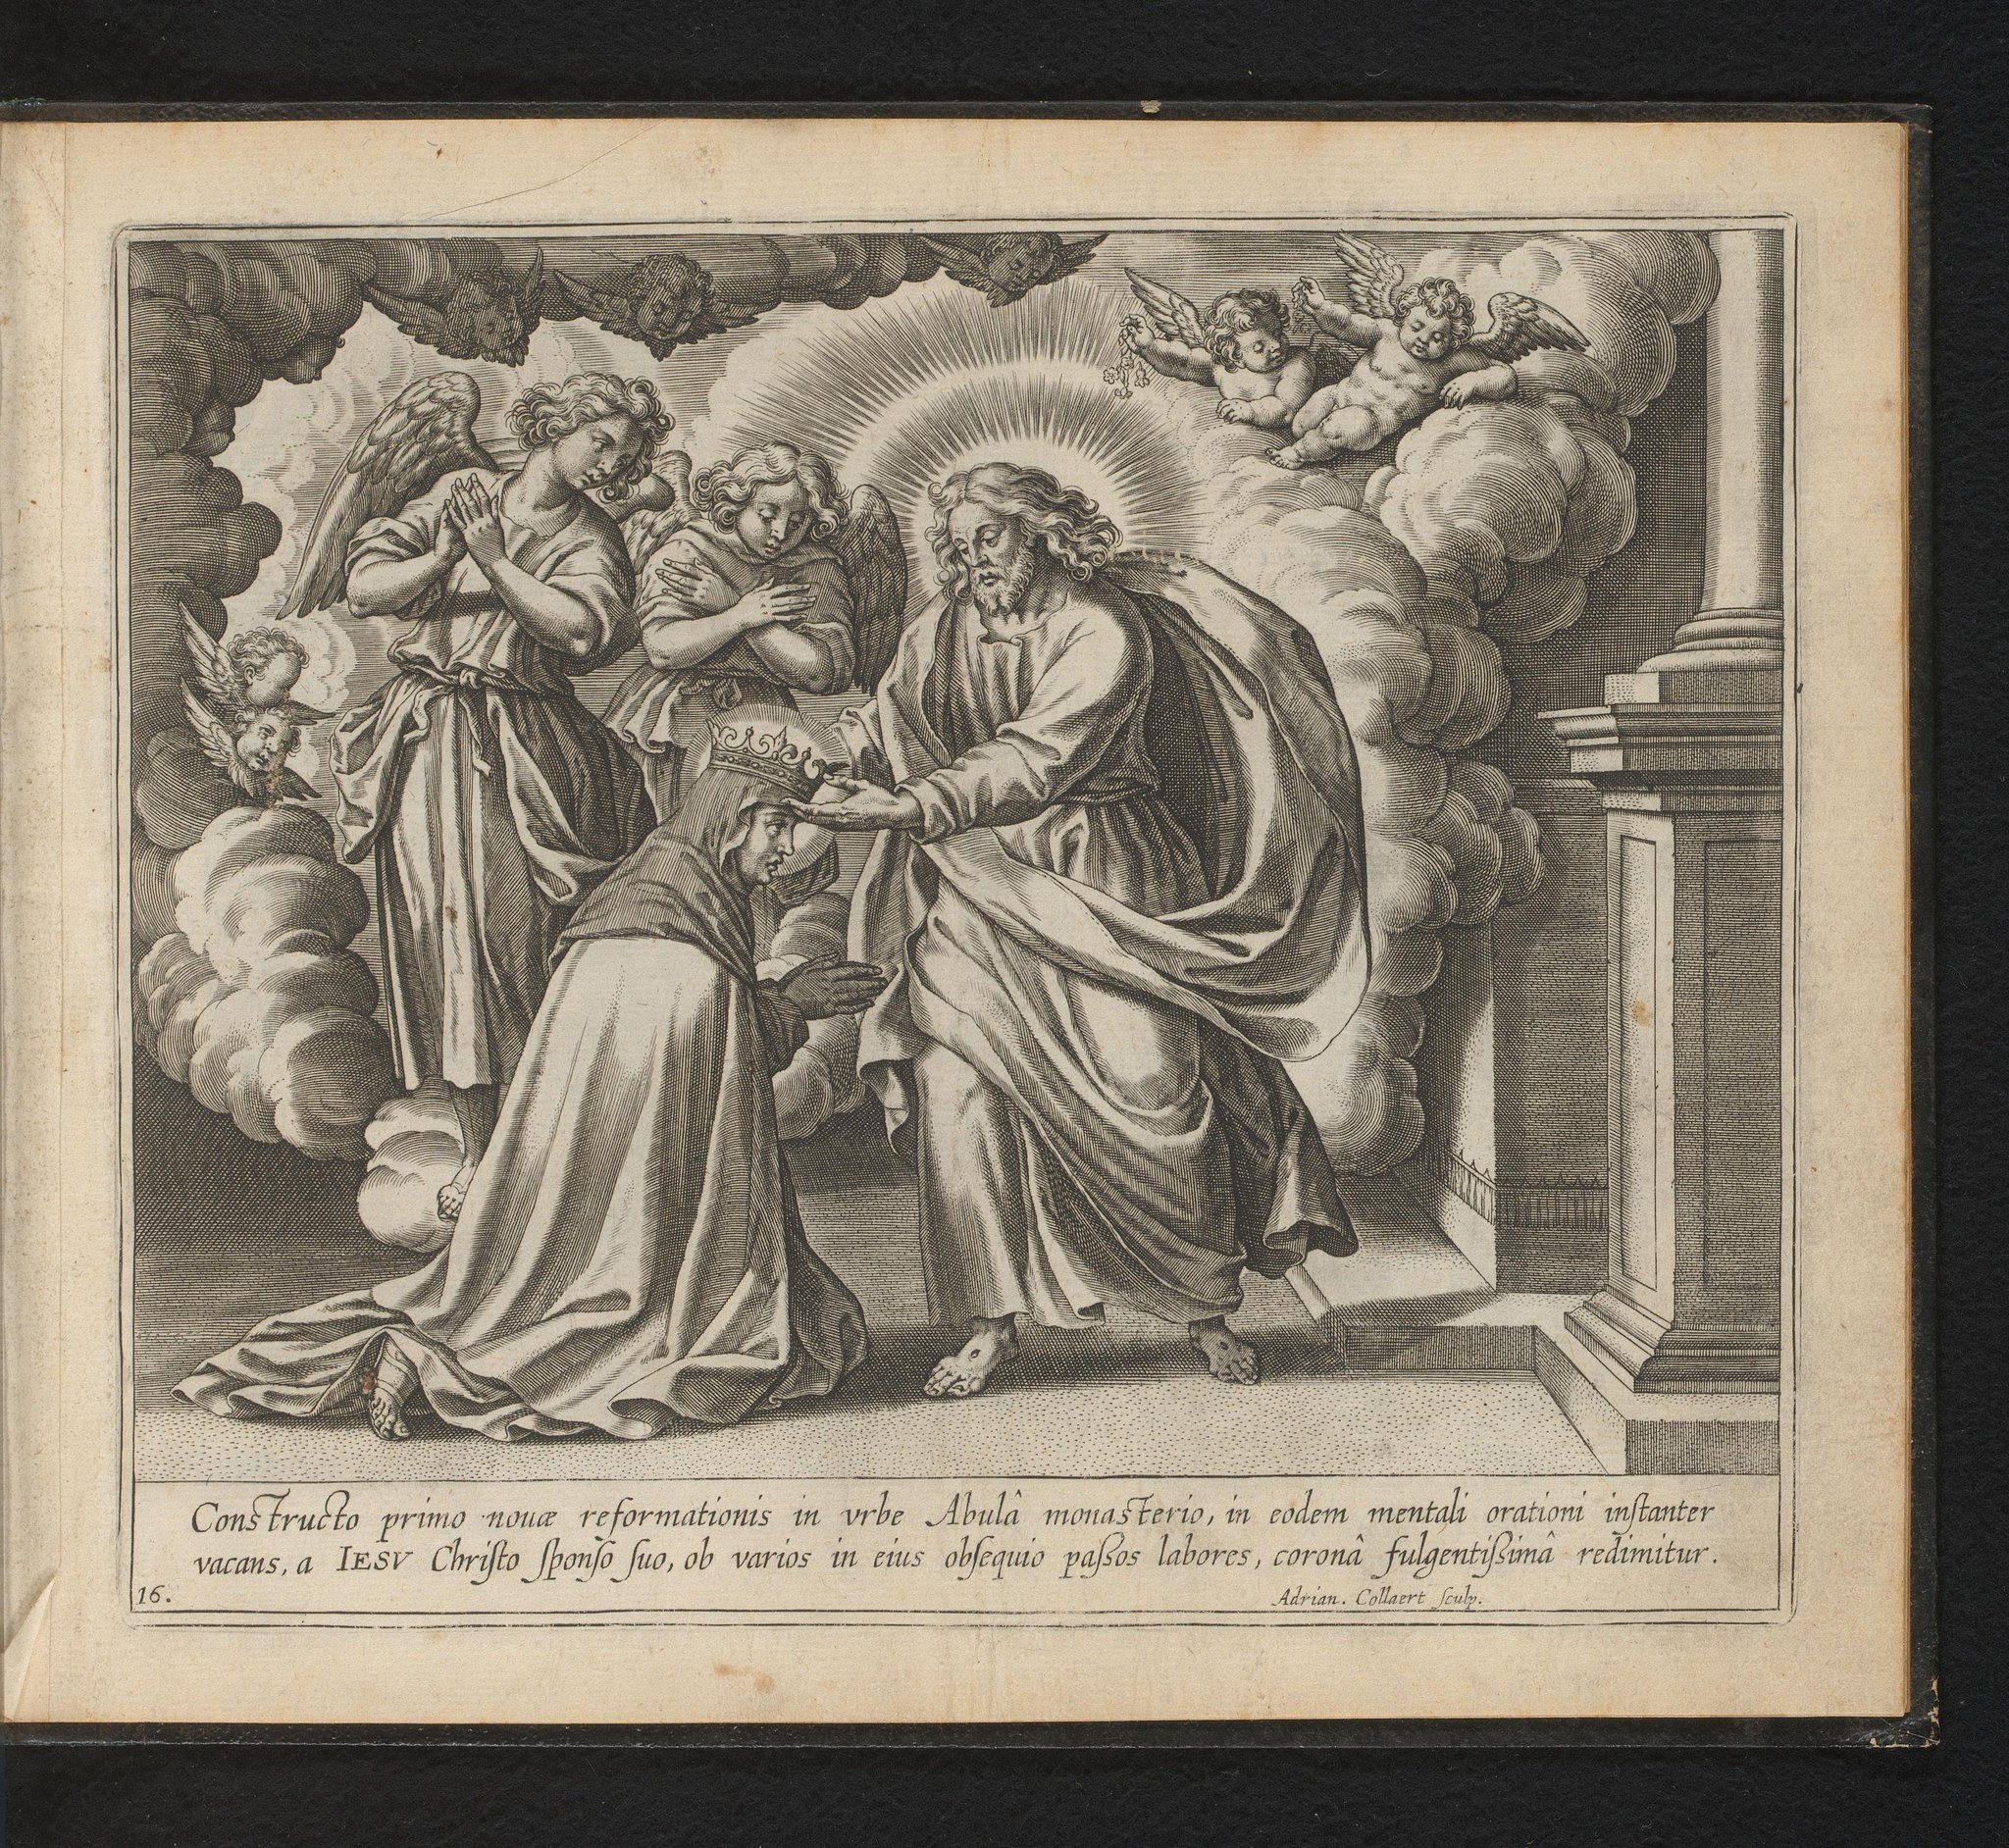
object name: print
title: De H. Theresa door Christus gekroond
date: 1613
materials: paper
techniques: engraving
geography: antwerp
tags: christ, crowned with thorns, appears to st. theresa and displays his wounds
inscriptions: number: ‘16’, signature: ‘Adrian Collaert sculp.’, caption: ‘Constructo primo novae reformationis...fulgentissima redimitur.’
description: Prent in album 'Vita B. Virginis Teresiae A. Jesu ordinis carmelitarum excalceatorum piae restauratricis..., 1613.